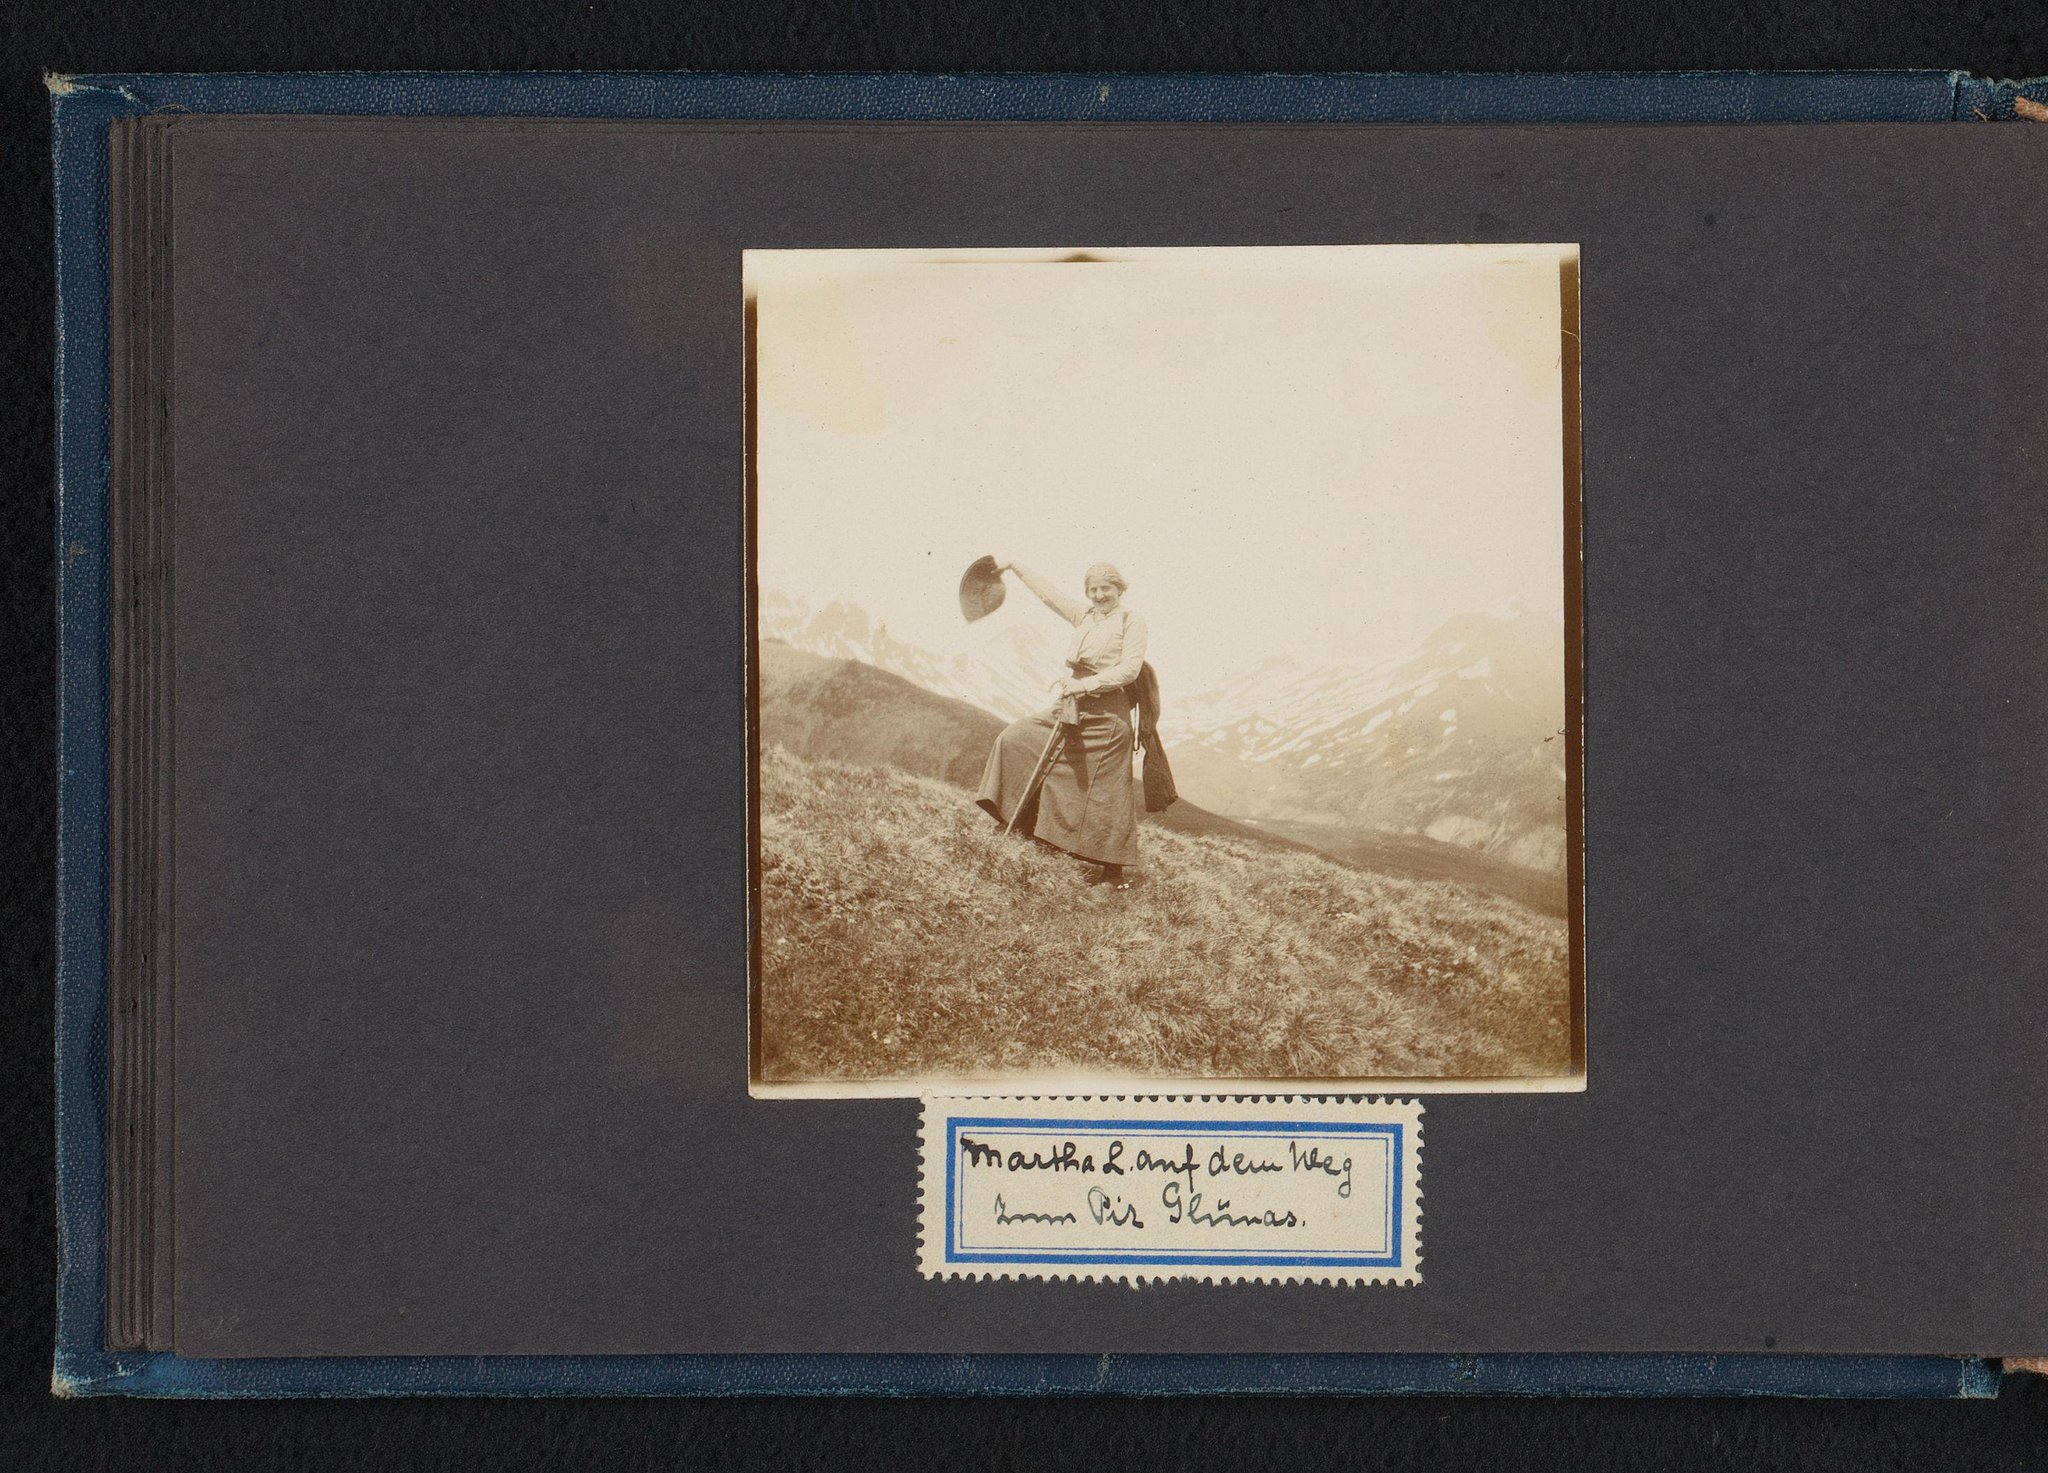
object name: photograph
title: Bergwandeling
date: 1913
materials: paper, photographic support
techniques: gelatin silver print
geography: switzerland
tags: else wachenheimer-moos, the family travelling, on holiday, walking, hiking (recreation), switzerland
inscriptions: inscription: ‘Martha L. auf dem Weg zu Piz Glünas [Clünas]’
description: Albumblad met een foto van Martha tijdens een bergwandeling, in Zwitserland. Onderdeel van het fotoalbum van Else Wachenheimer-Moos en haar broers Arthur en Willy Moos en anderen in de periode 1913-1918.